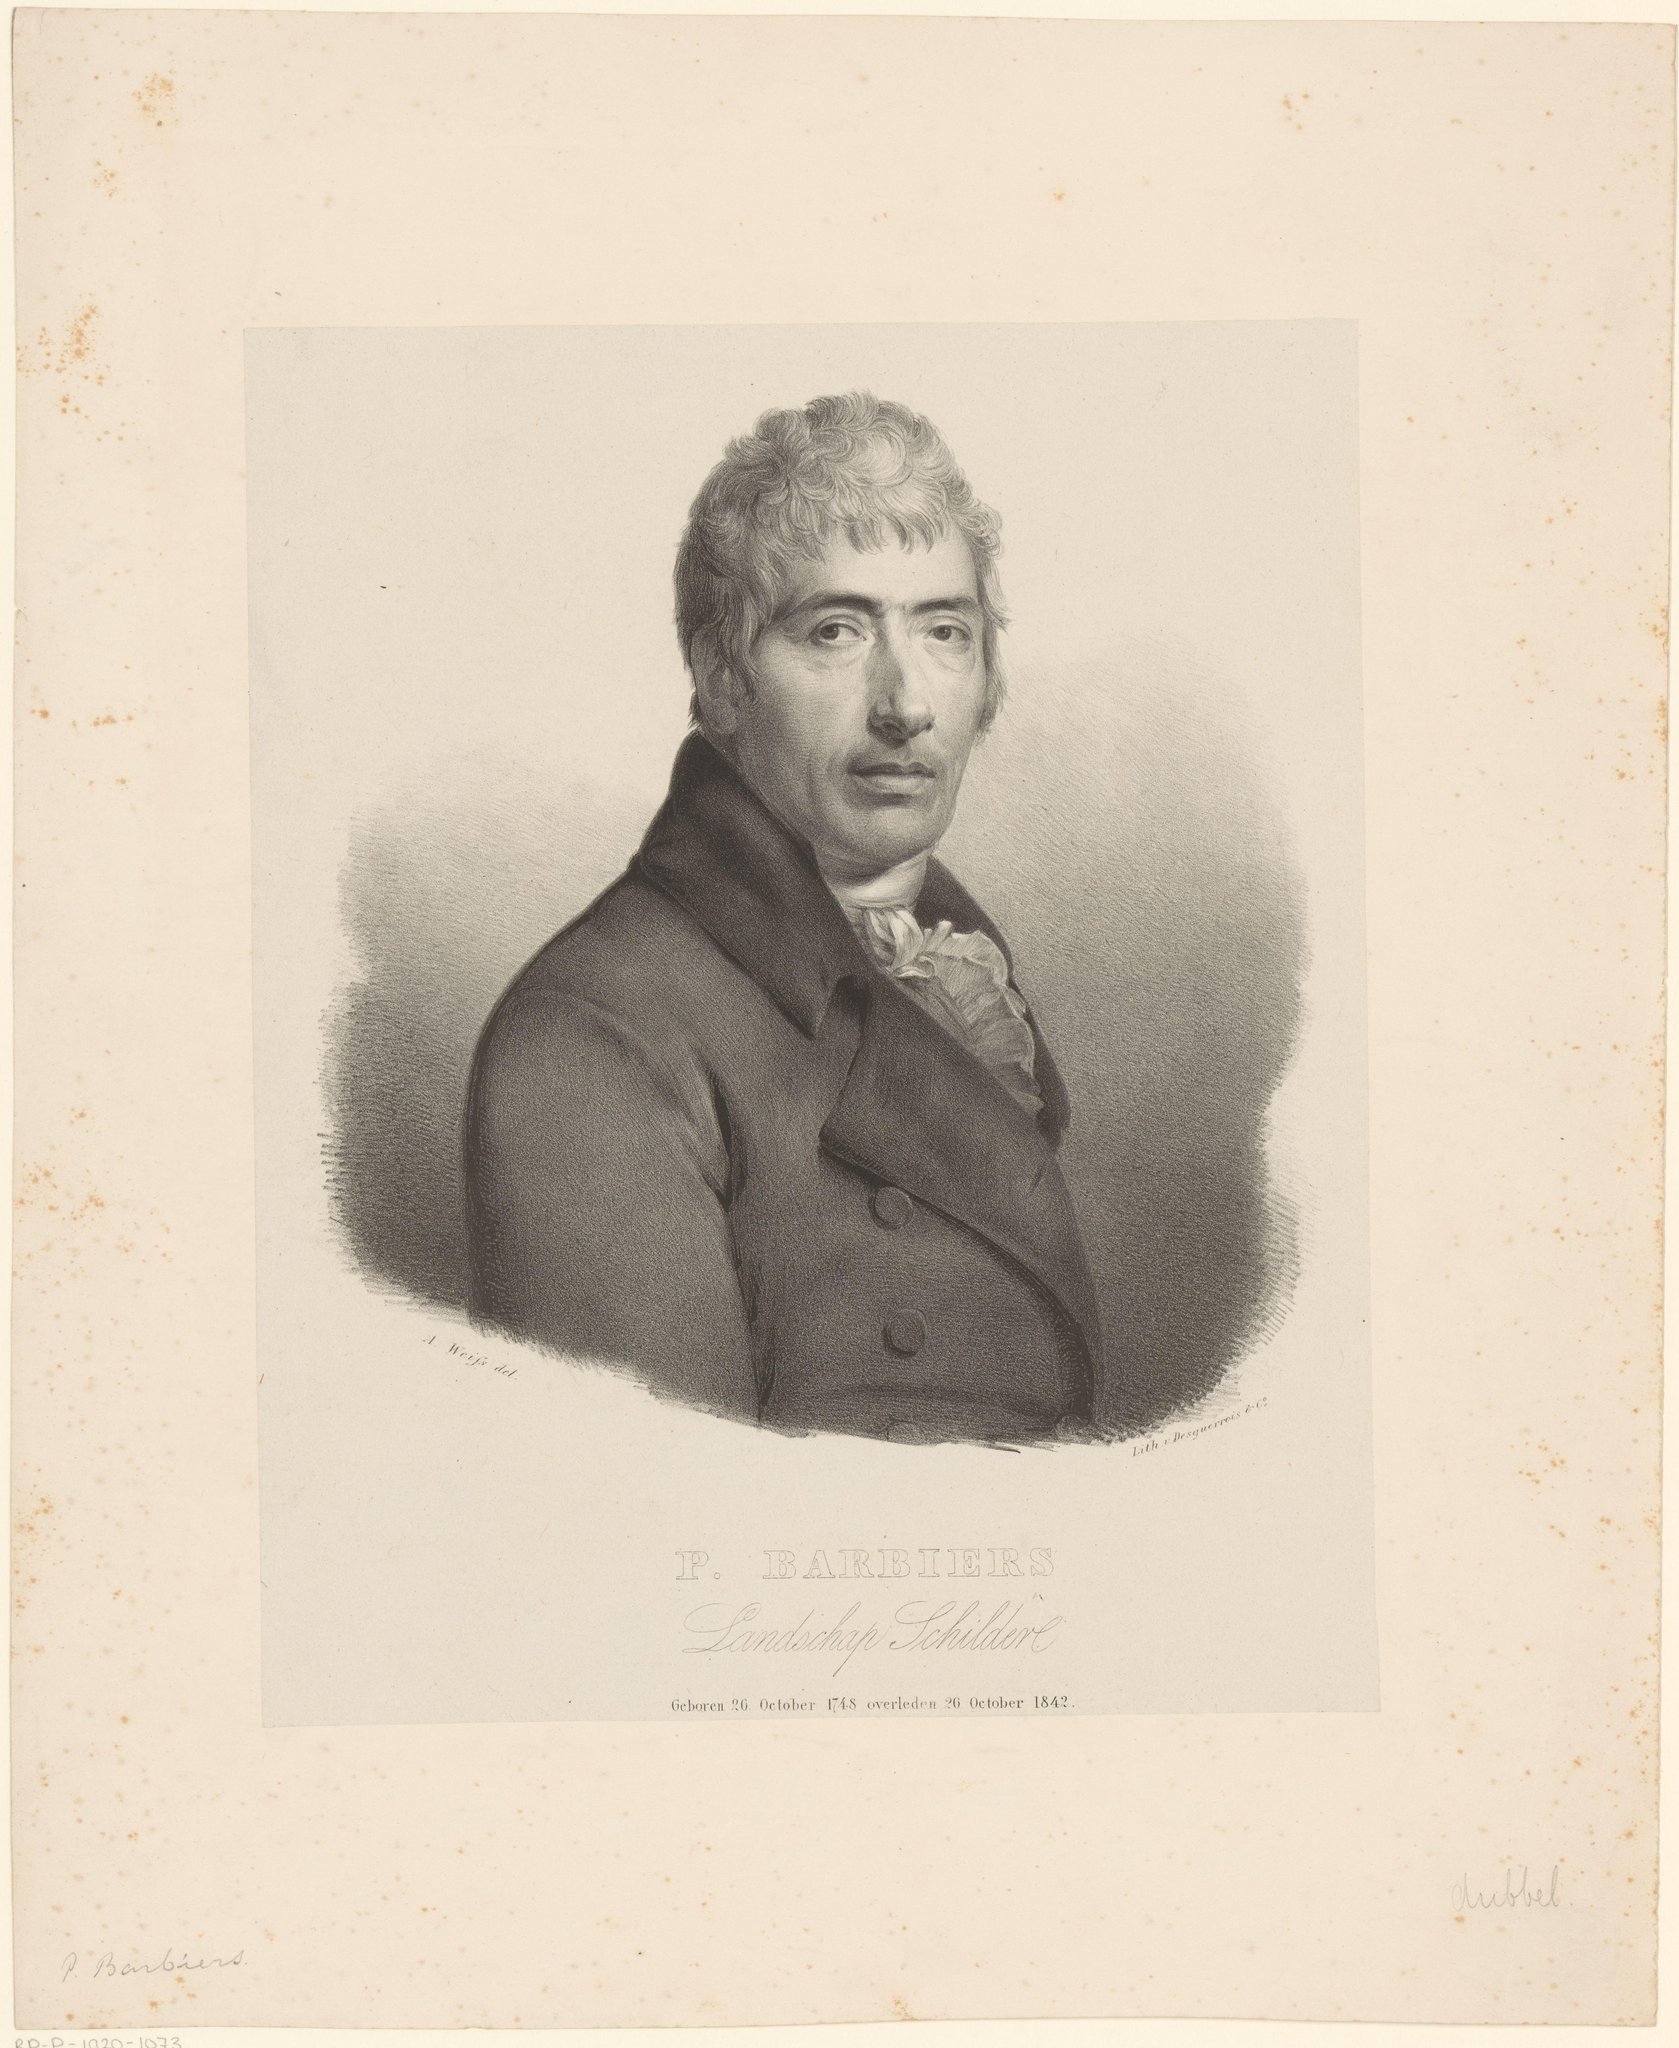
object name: print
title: Portret van Pieter Pietersz. Barbiers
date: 1842-1851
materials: paper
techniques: lithograph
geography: amsterdam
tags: amsterdam, draughtsman, pieter pietersz. barbiers, historical persons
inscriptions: collector's mark: Lugt 2228